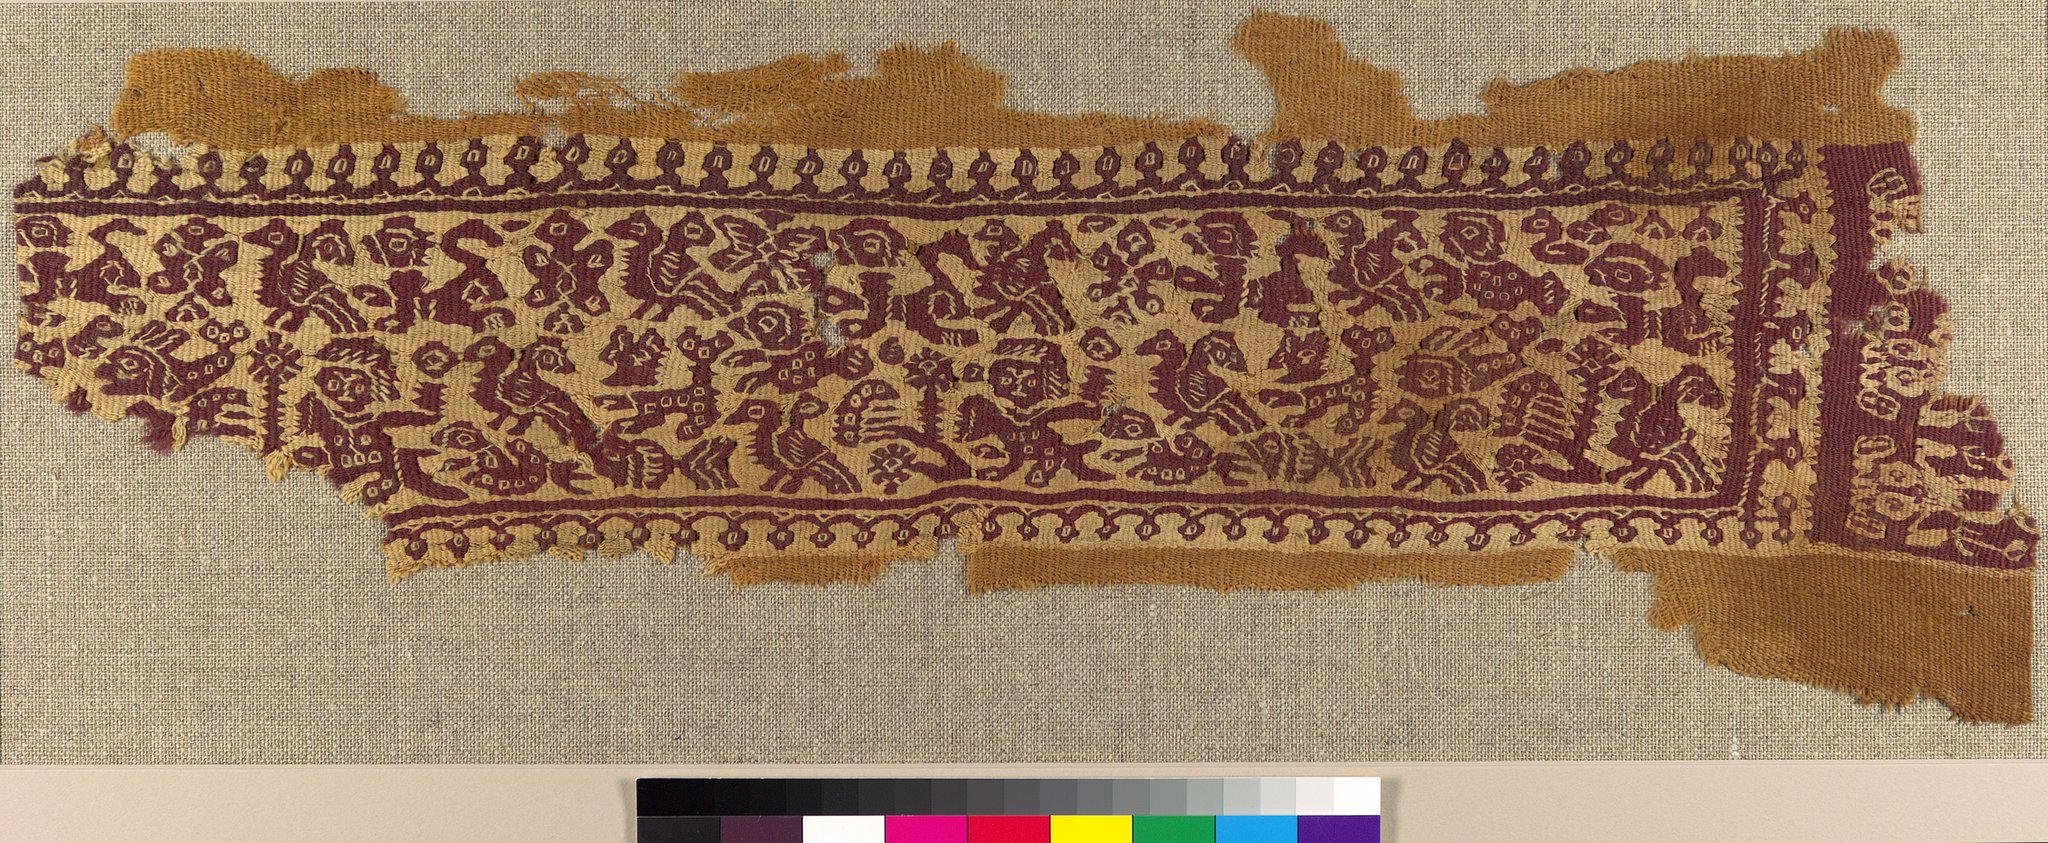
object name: textile fragment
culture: byzantine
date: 701-1000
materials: linen, wool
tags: birds